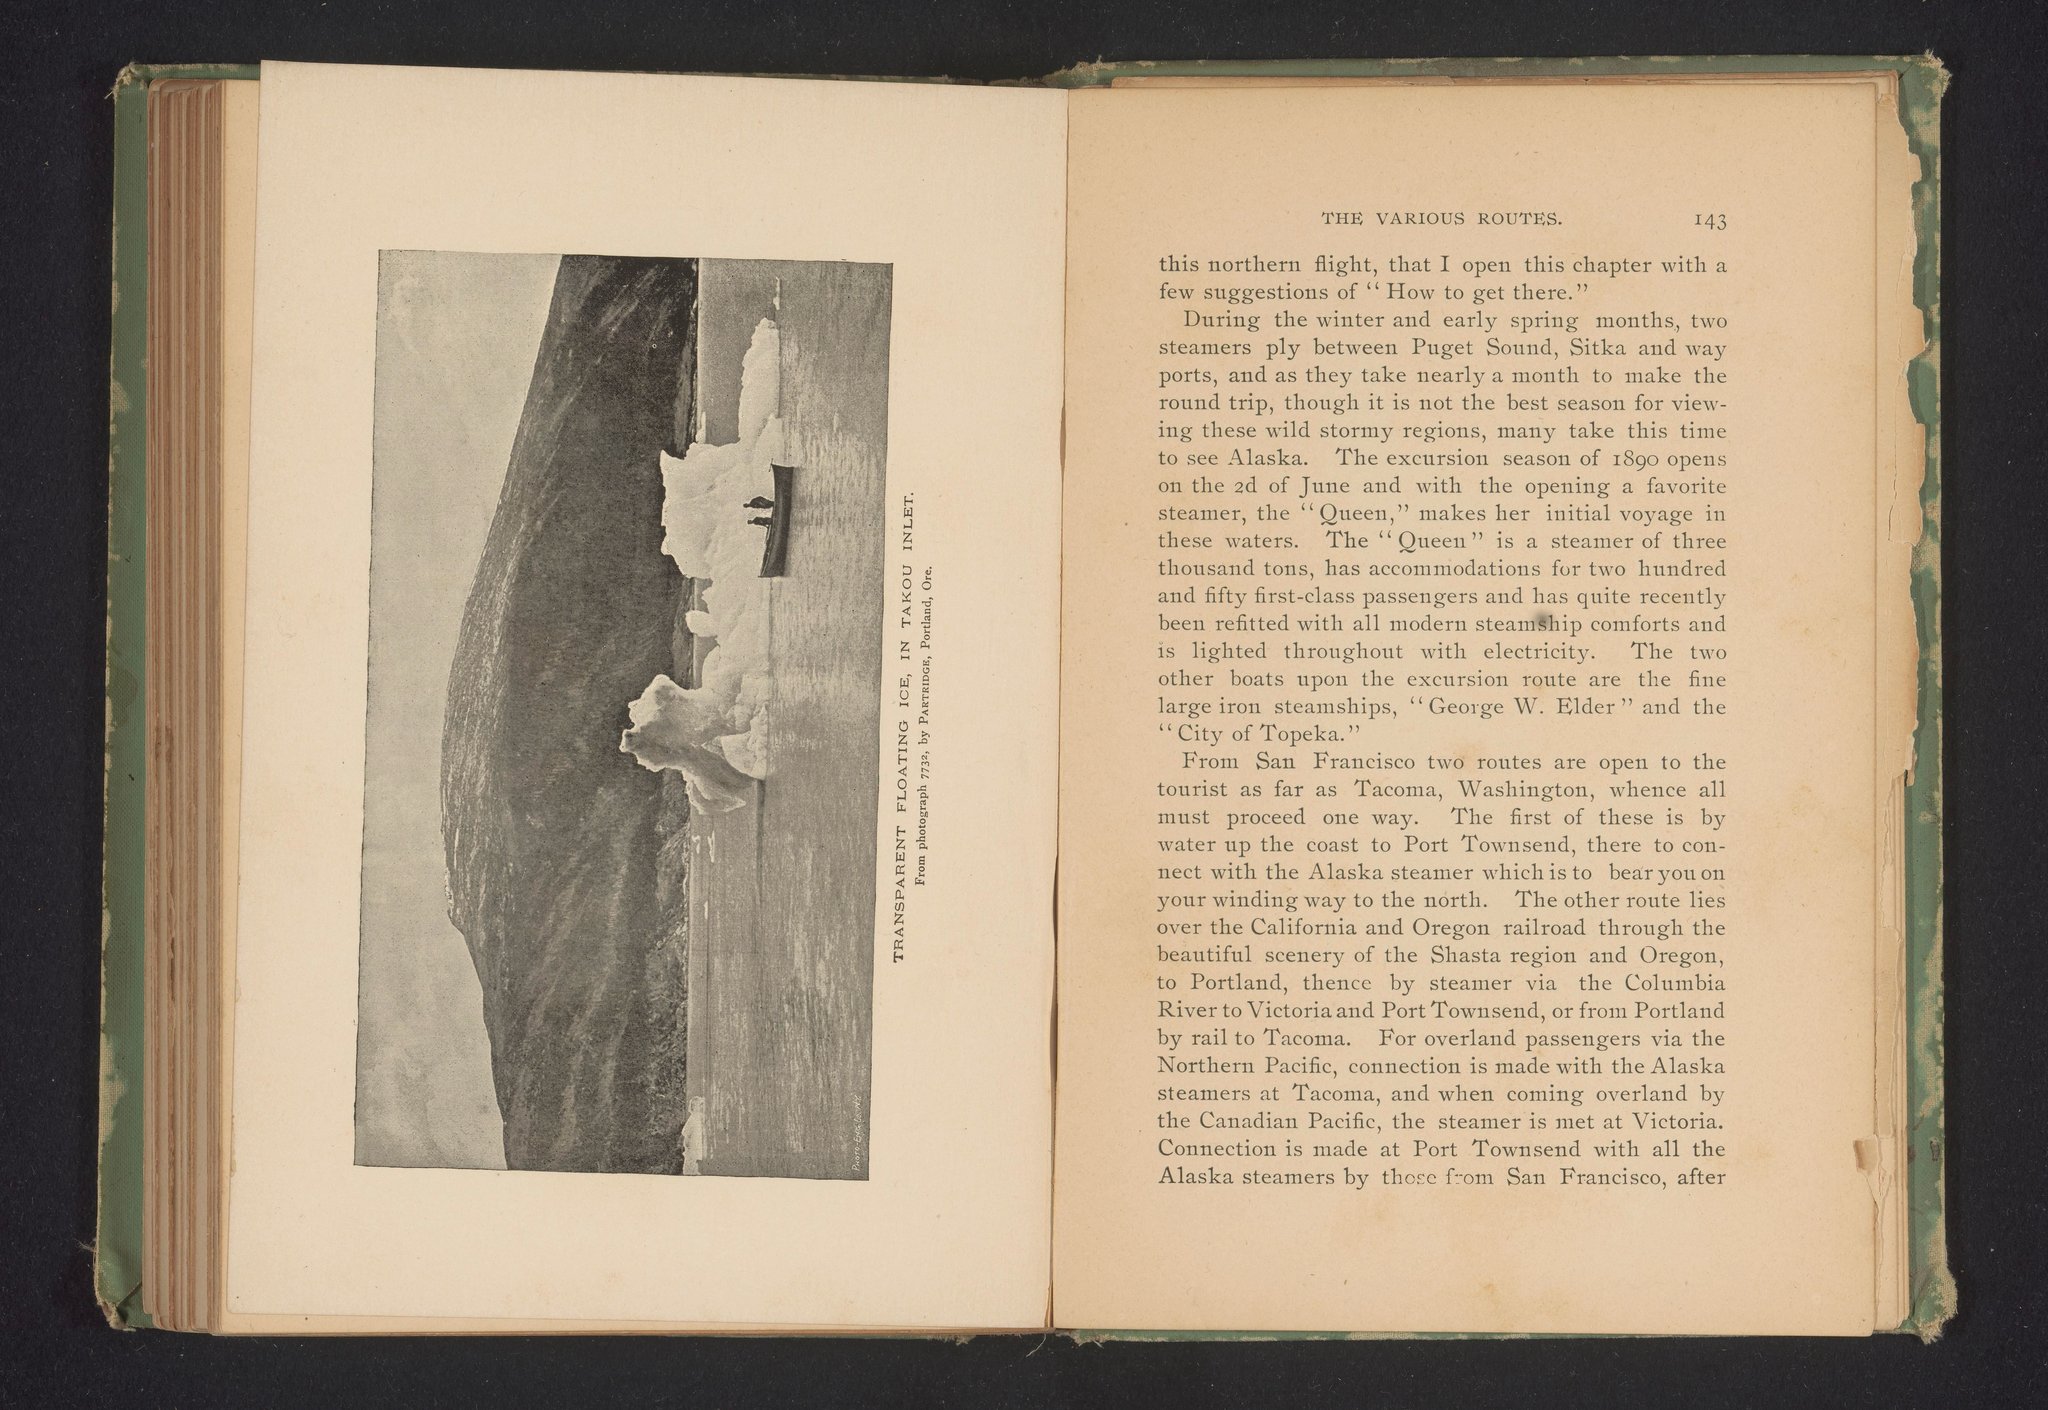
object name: photomechanical print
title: Landschap met ijsschots en twee mensen in een bootje in Taku Inlet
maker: william henry partridge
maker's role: fotograaf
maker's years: 1858-1939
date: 1885-1890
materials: paper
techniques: autotype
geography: juneau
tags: landscapes, iceberg, rowing-boat, canoe, etc.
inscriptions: inscription: ‘From photograph 7732, by Partridge, Portland, Ore.’